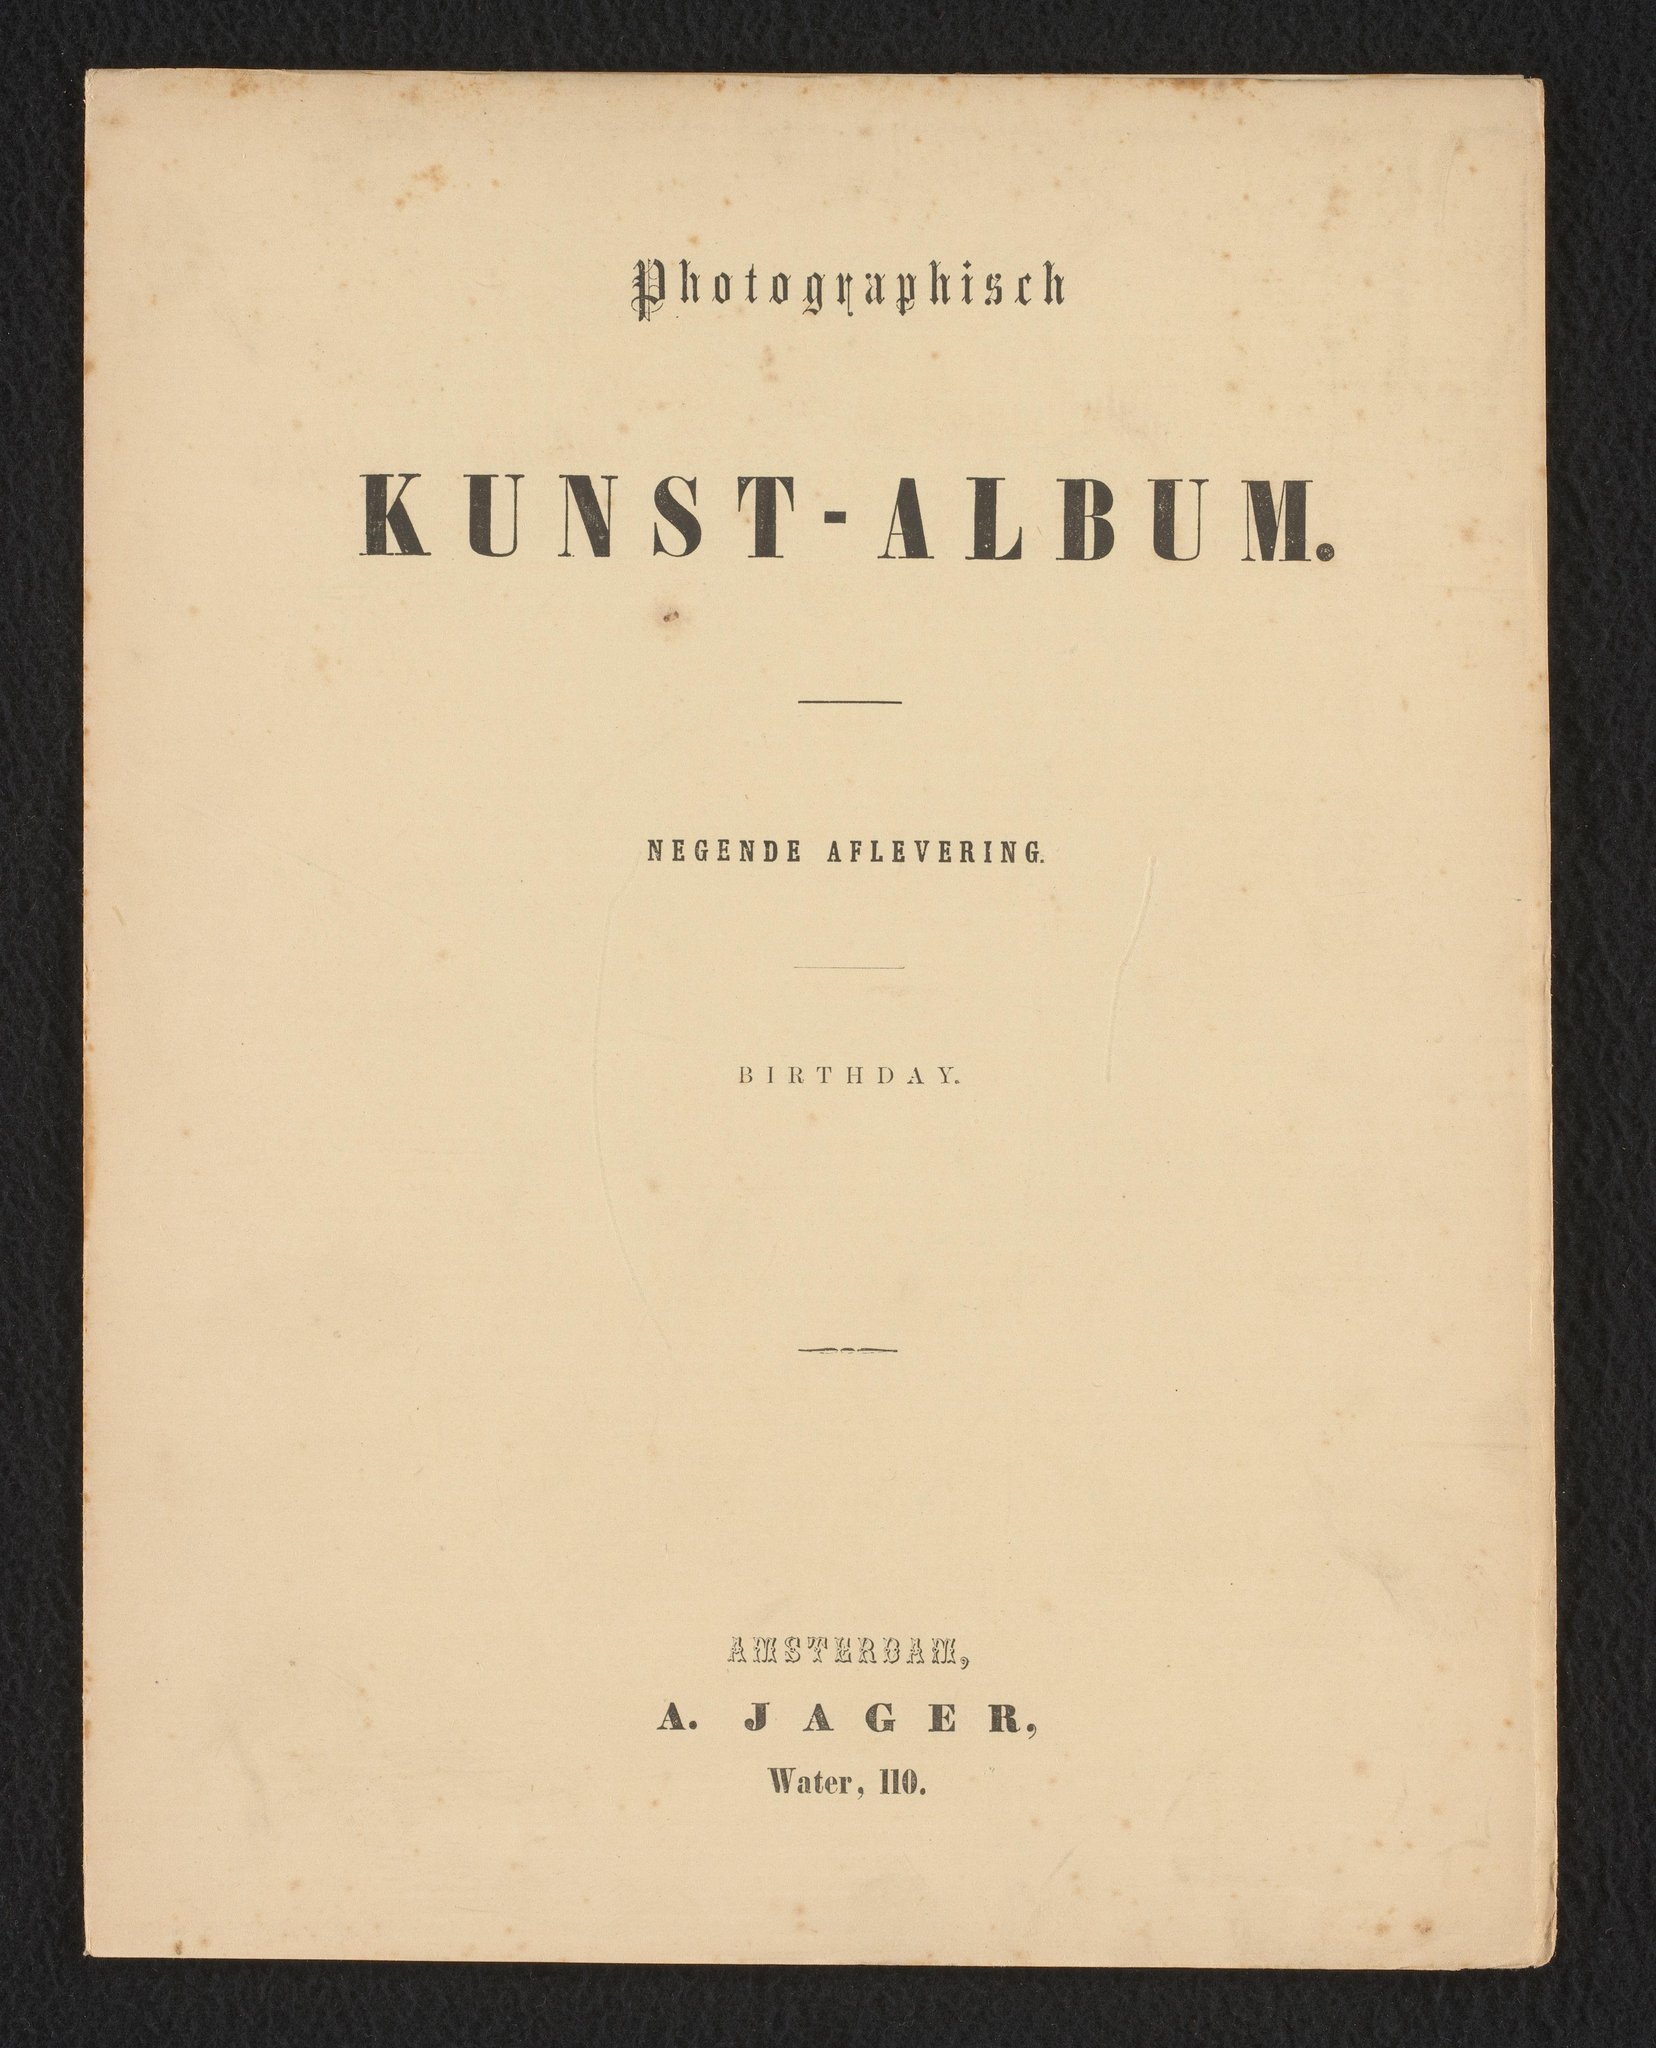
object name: wrapper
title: Omslag voor een fotoreproductie van het schilderij Birthday naar Adolphe Dubasty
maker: andries jager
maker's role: publisher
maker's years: 1825-1905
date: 1860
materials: paper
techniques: printing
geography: amsterdam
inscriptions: address: ‘AMSTERDAM,/ A. JAGER,/ Water, 110.’, inscription: ‘BIRTHDAY./ NAAR EENE SCHILDERIJ/ VAN/ A. H. DUBASTY.’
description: Deze omslag maakt deel uit van een omslag met twaalf fotoreproducties.